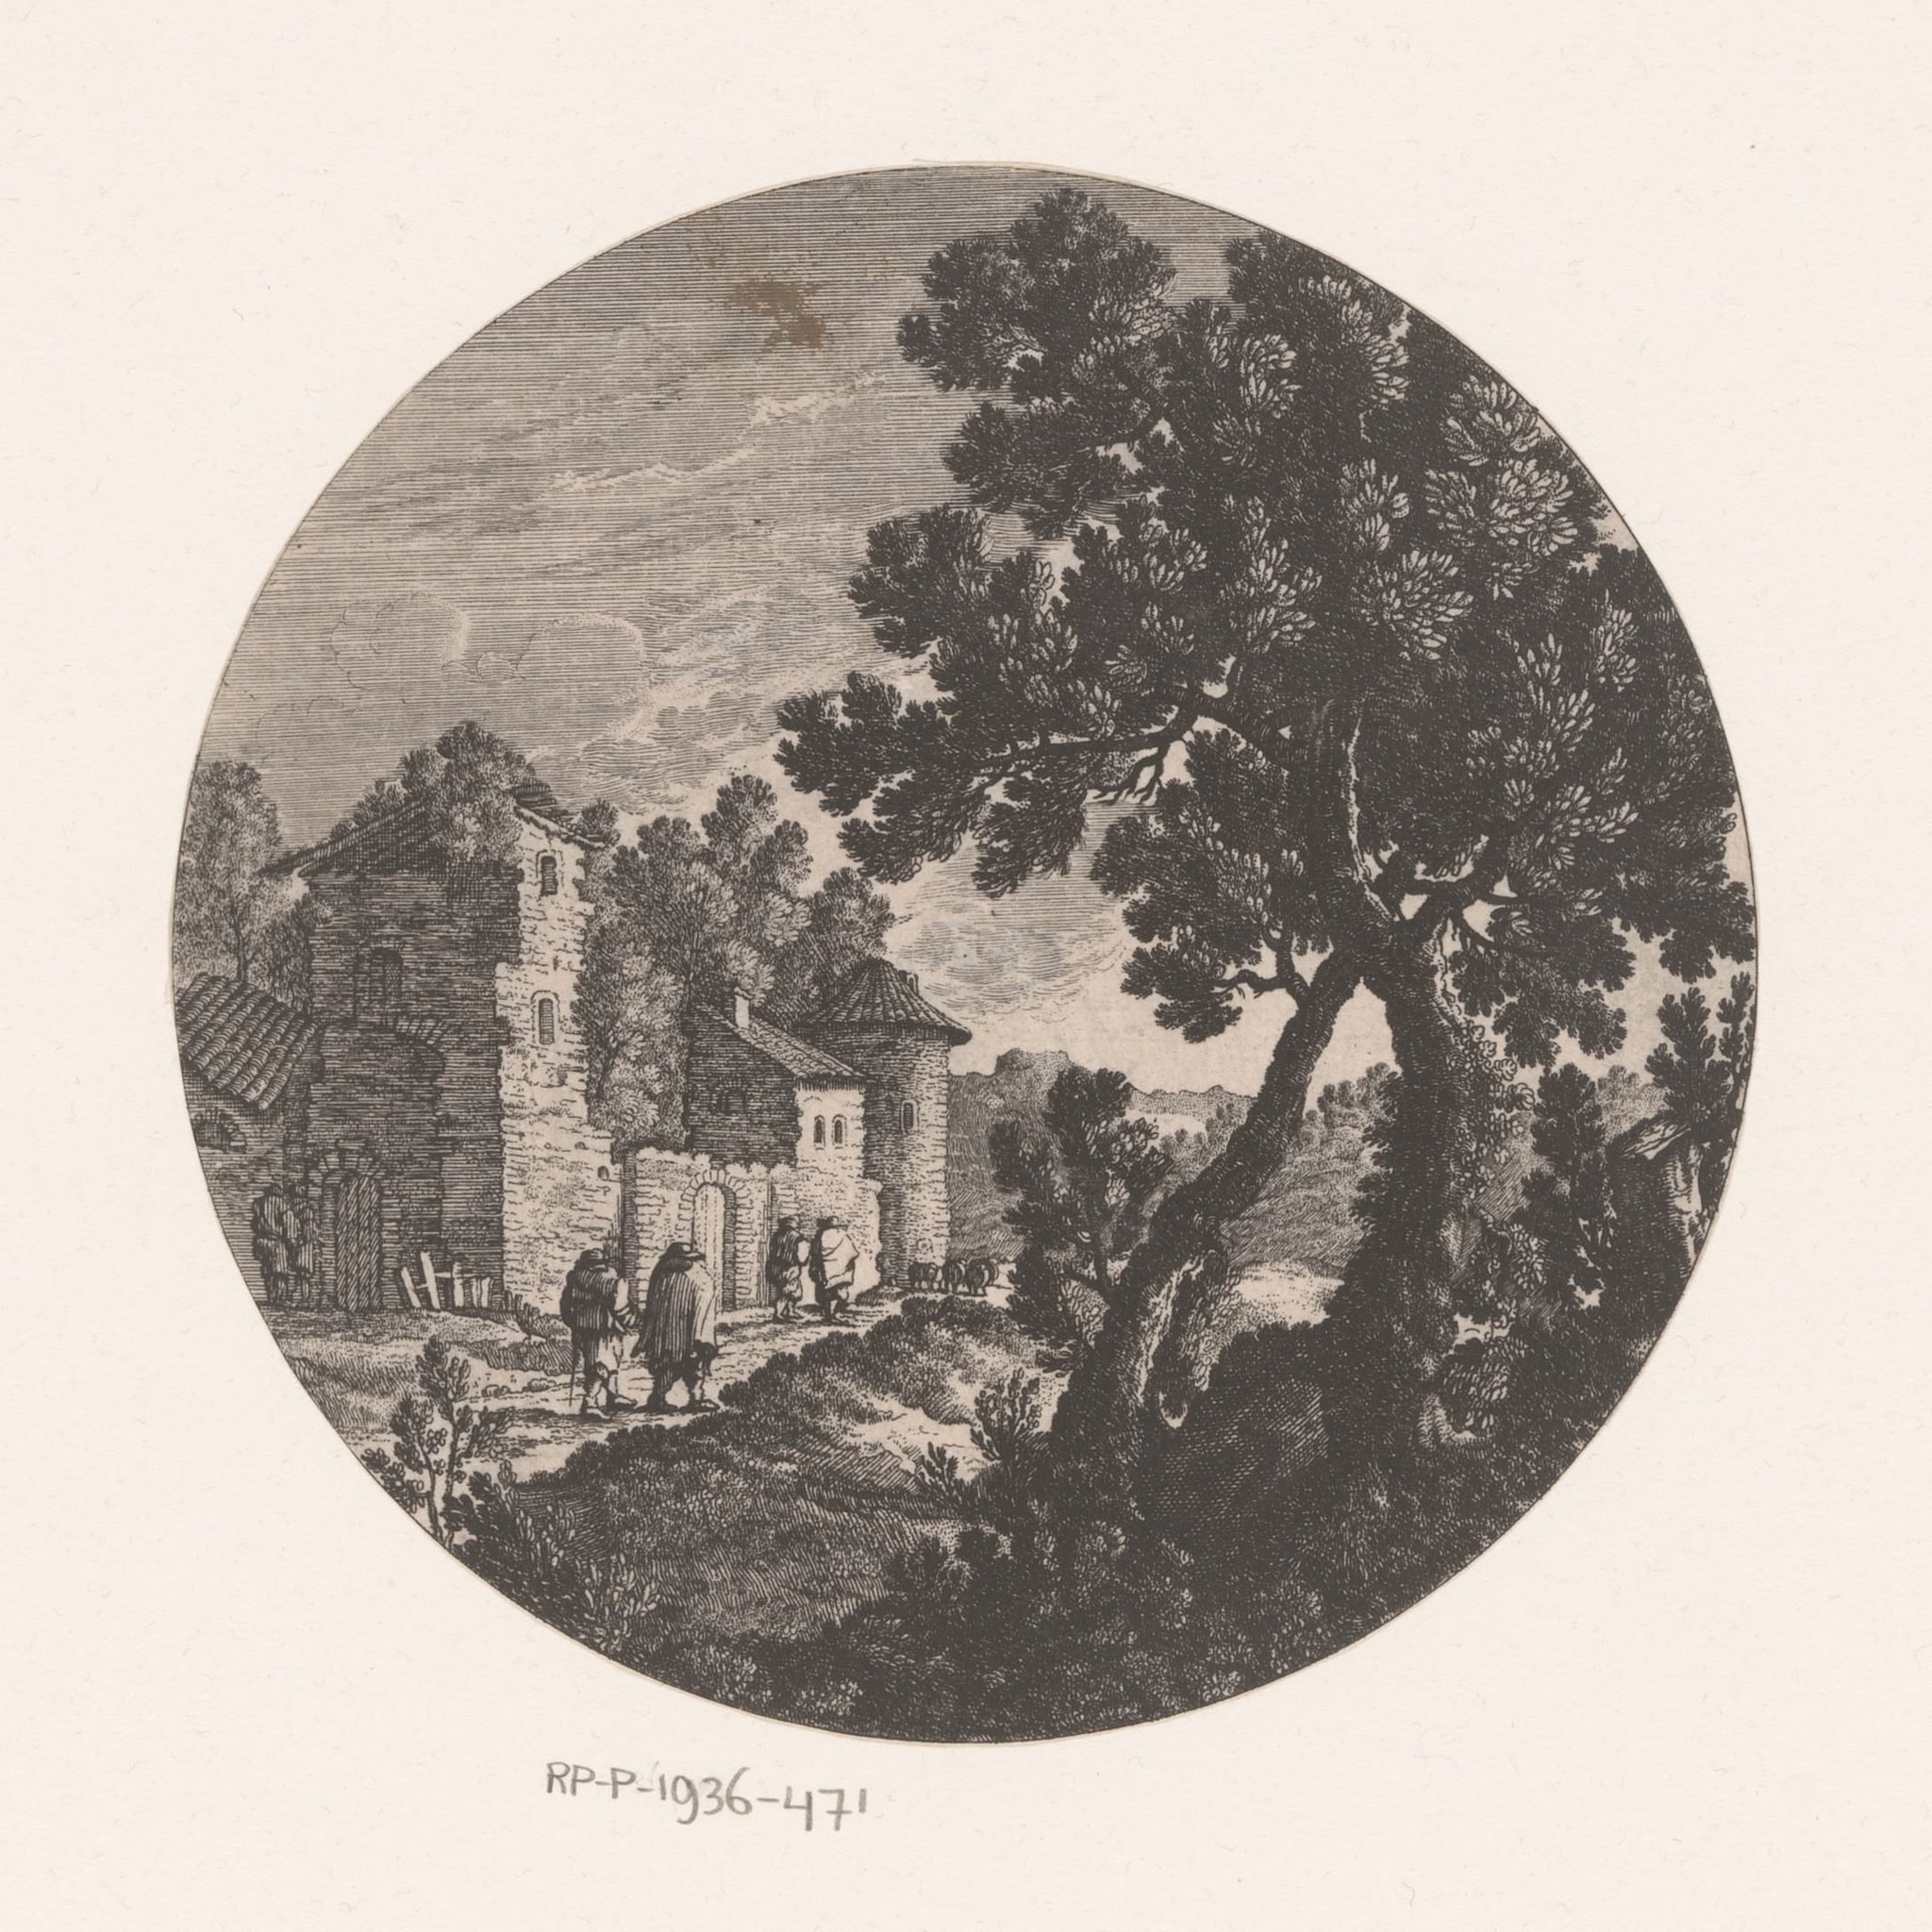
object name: print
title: Landschap met figuren en huizen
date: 1613-1695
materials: paper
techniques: etching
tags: landscapes, outskirts of village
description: Prenten met het signatuur 'Perelle' kunnen zowel door vader Gabriel als door zonen Nicolas en Adam gemaakt zijn.